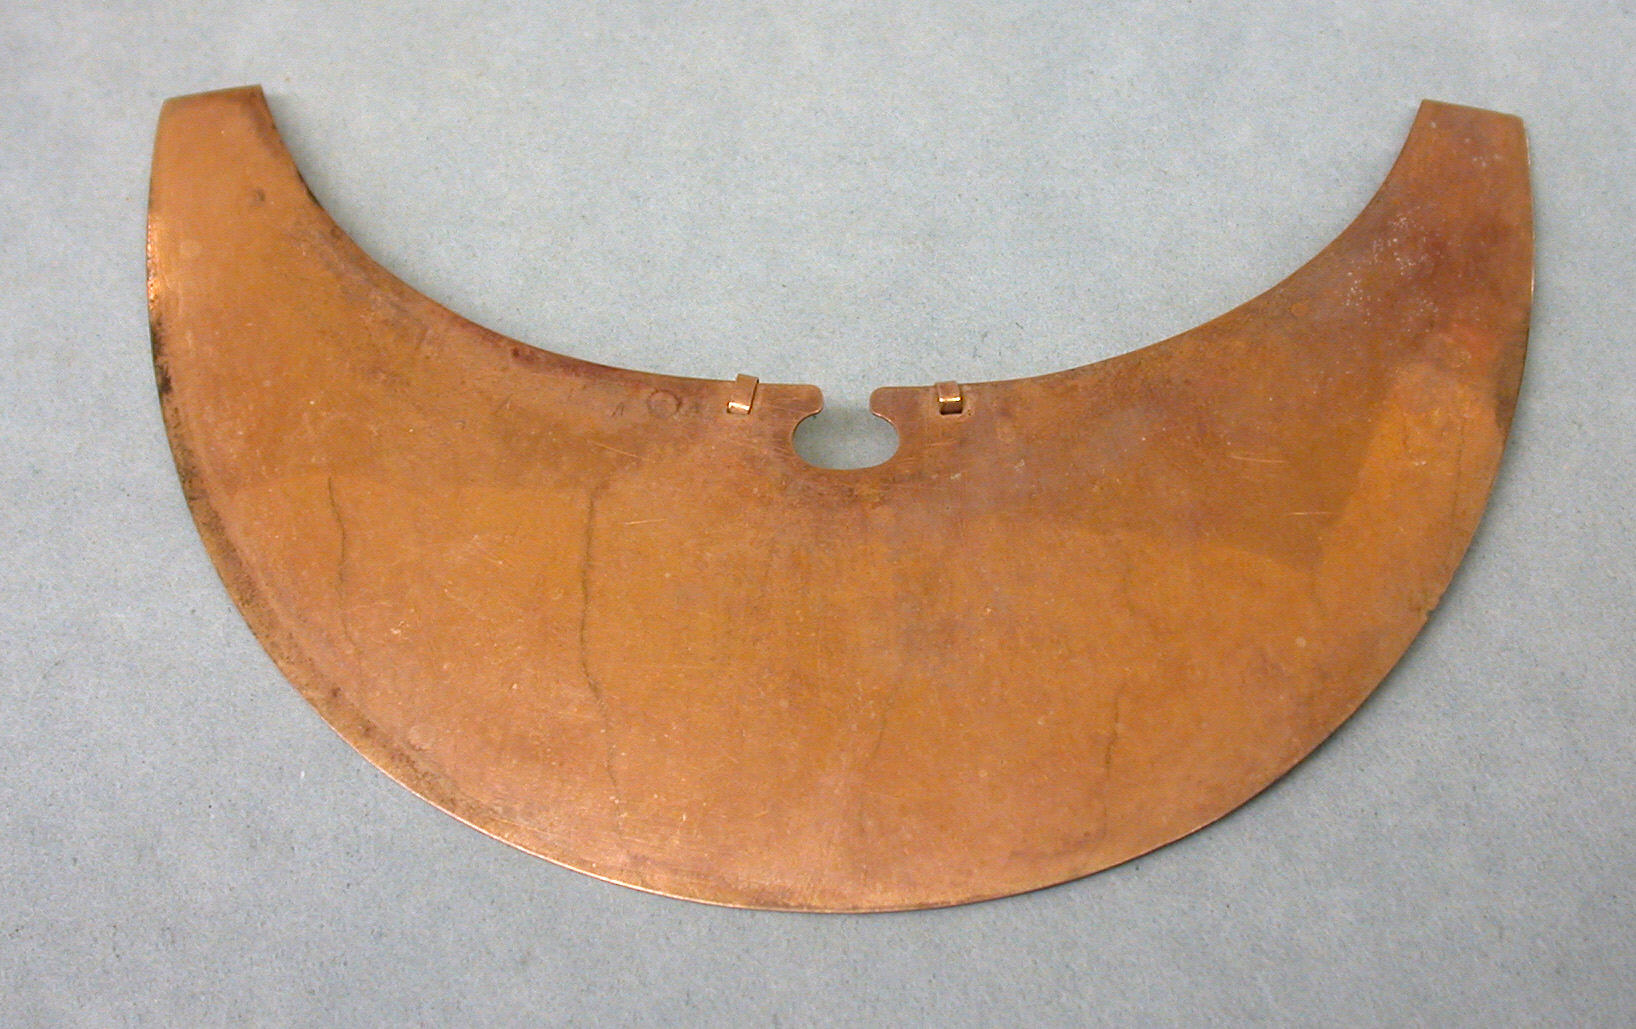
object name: nose ornament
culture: moche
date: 1-300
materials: gold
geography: peru